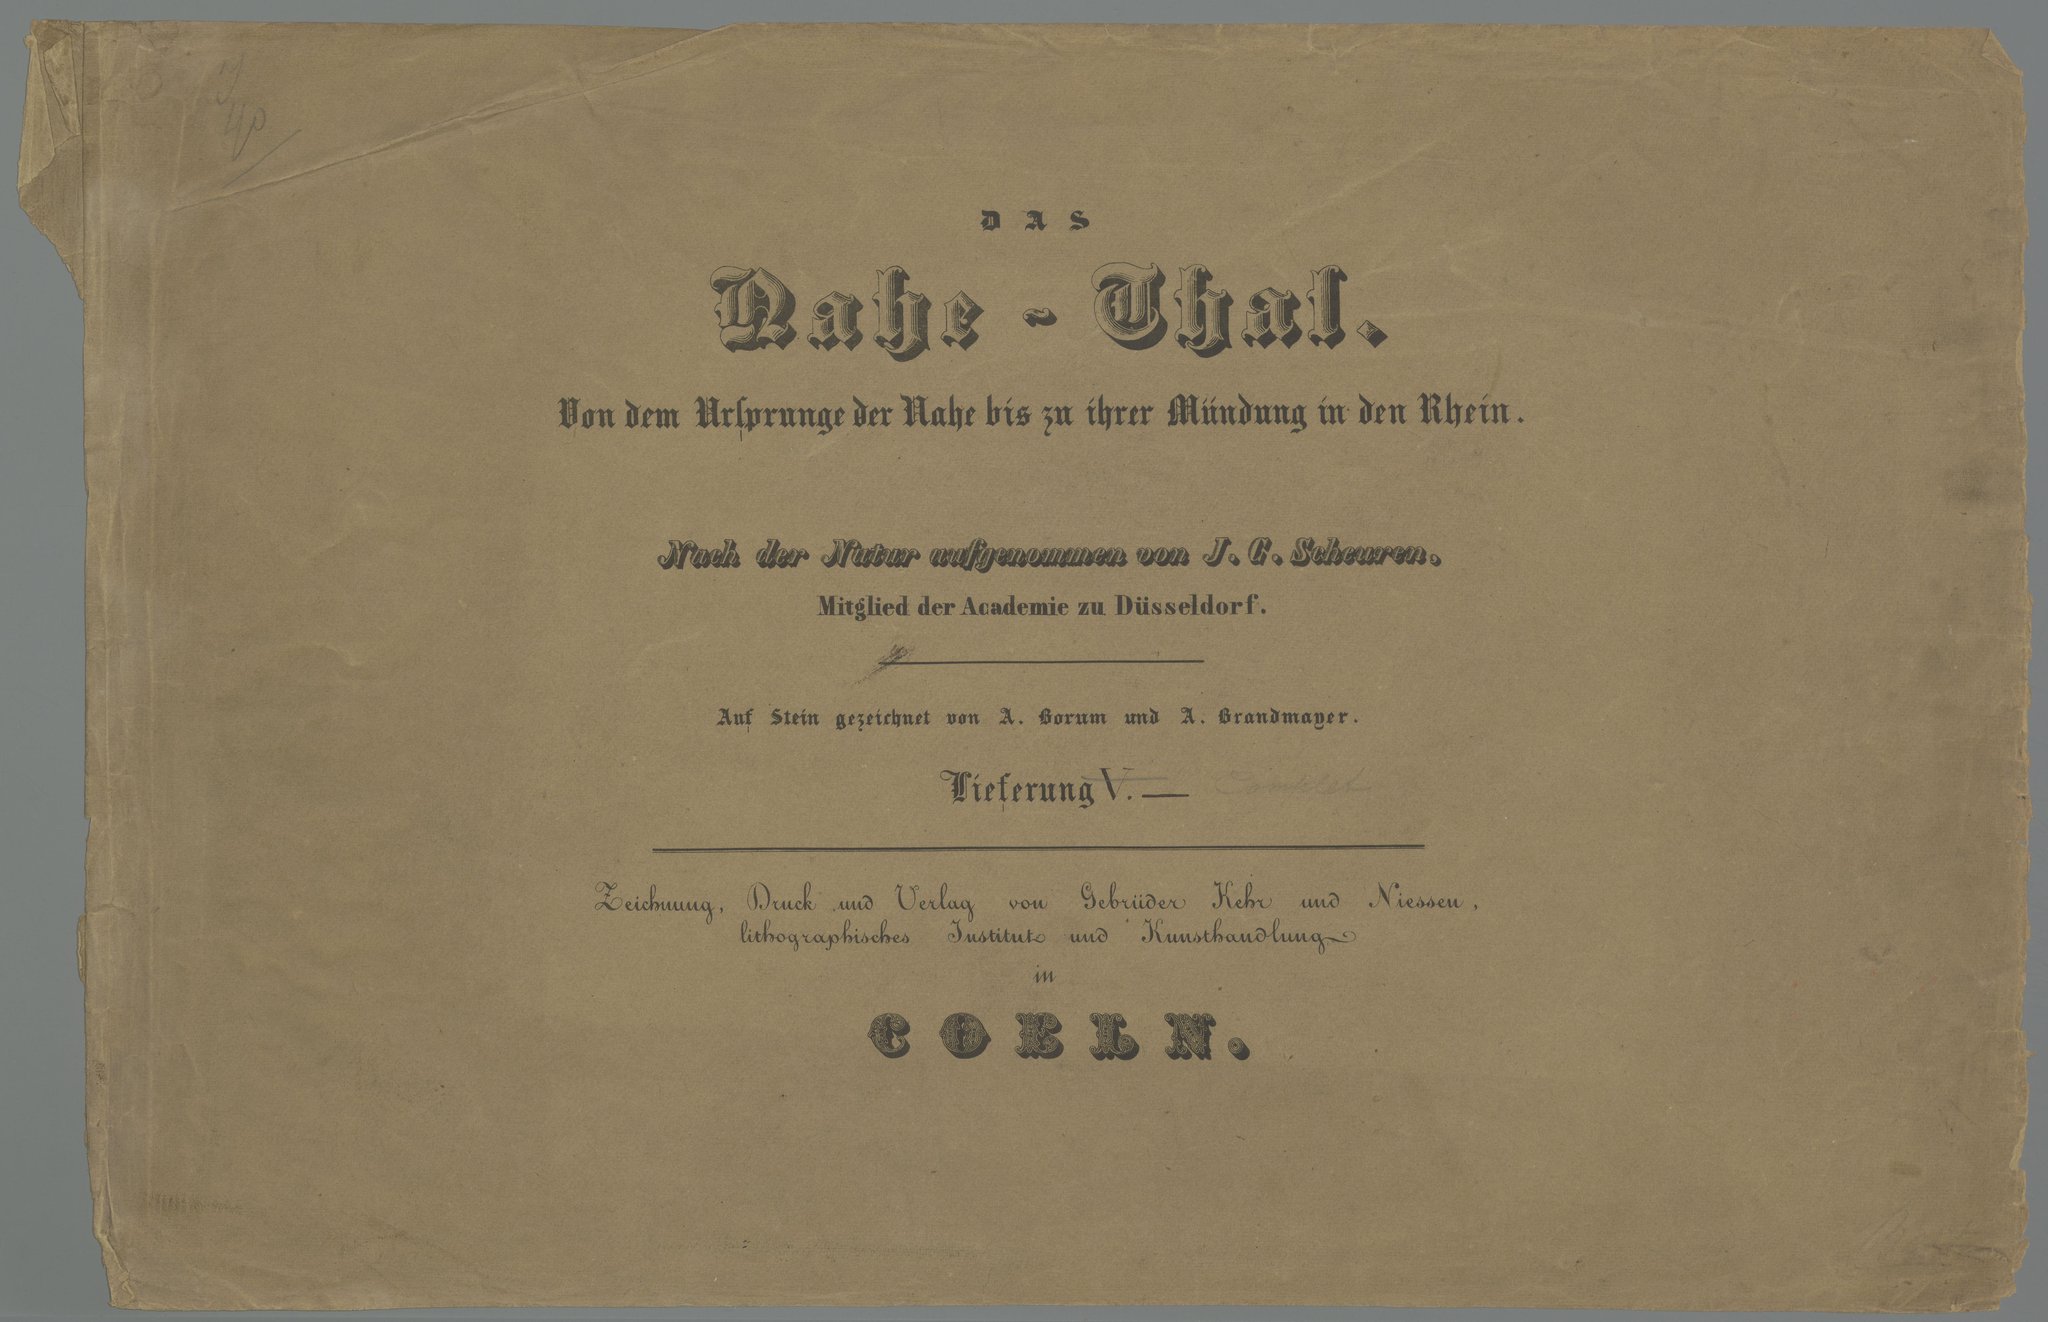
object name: wrapper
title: Gezichten op het Nahe dal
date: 1834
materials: paper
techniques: lithograph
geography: cologne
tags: nahe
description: De serie 'Das Nahe-Thal. Von dem Ursprunge der Nahe bis zu ihrer Mündung in den Rhein' is uitgegeven in vijf delen van elk vier prenten vervaardigd door A. Brandmayer en Andreas Borum. Tien prenten uit deze serie zijn daarnaast waarschijnlijk ook nog samen onder de titel 'Kreuznach und seine Umgebung. Erinnerung an seine Heilquellen und das Nahe-Thal' uitgegeven.